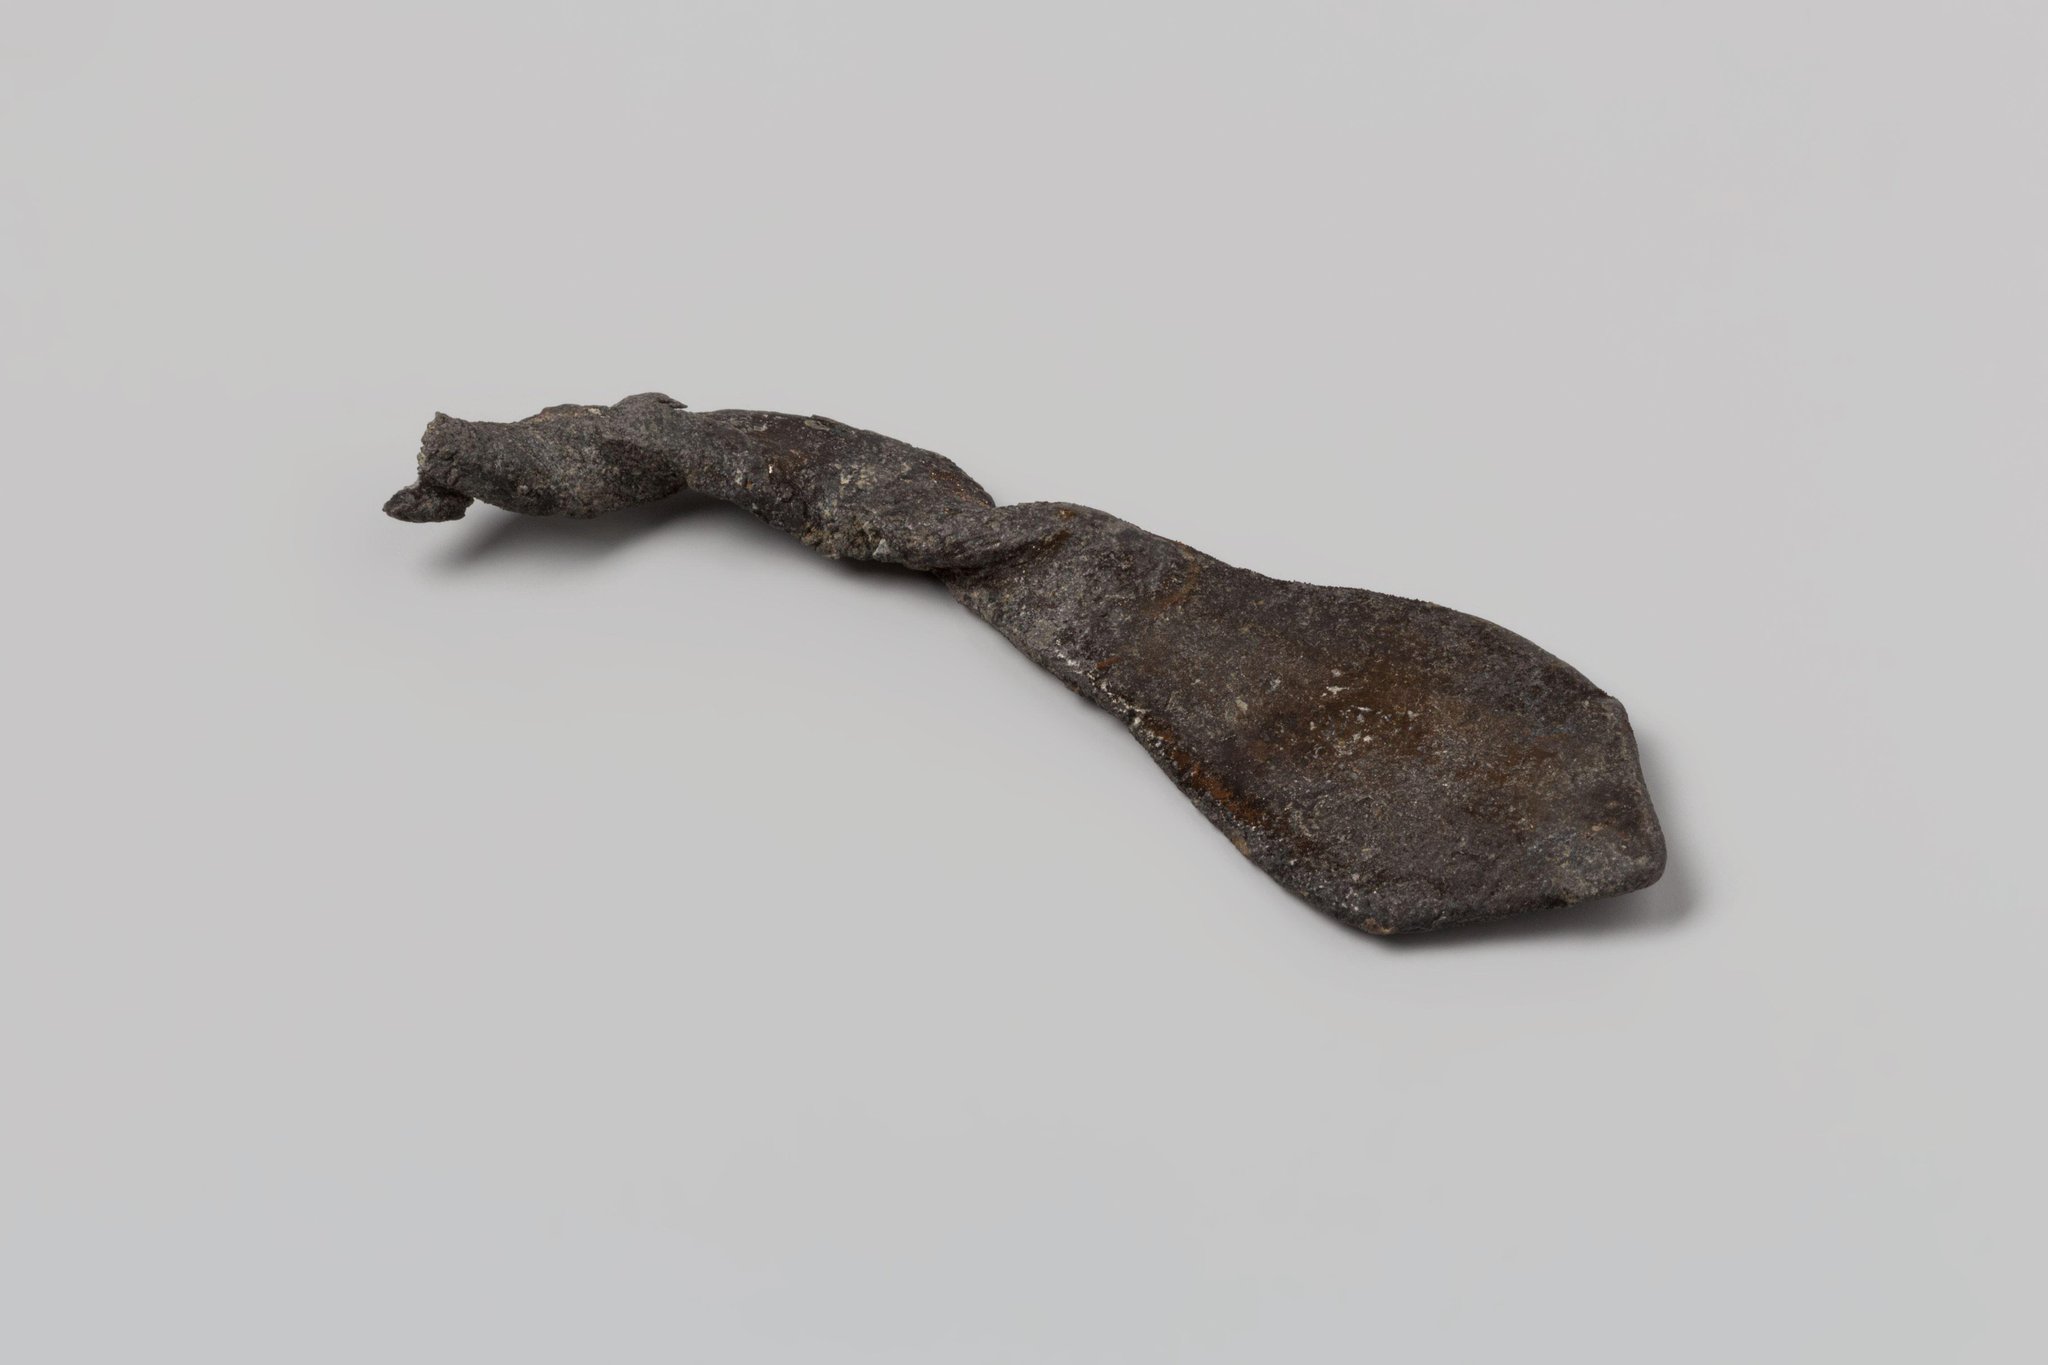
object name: spoon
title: Fragment steel van vork of lepel uit het wrak van de Oost-Indiëvaarder Hollandia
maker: Anonymous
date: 1700-1743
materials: tin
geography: netherlands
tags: verenigde oostindische compagnie, hollandia (schip), annet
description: Cutlery, fragment: stem of fork or spoon; fragm, flat, widening towards triangularly pointed end, twisted.